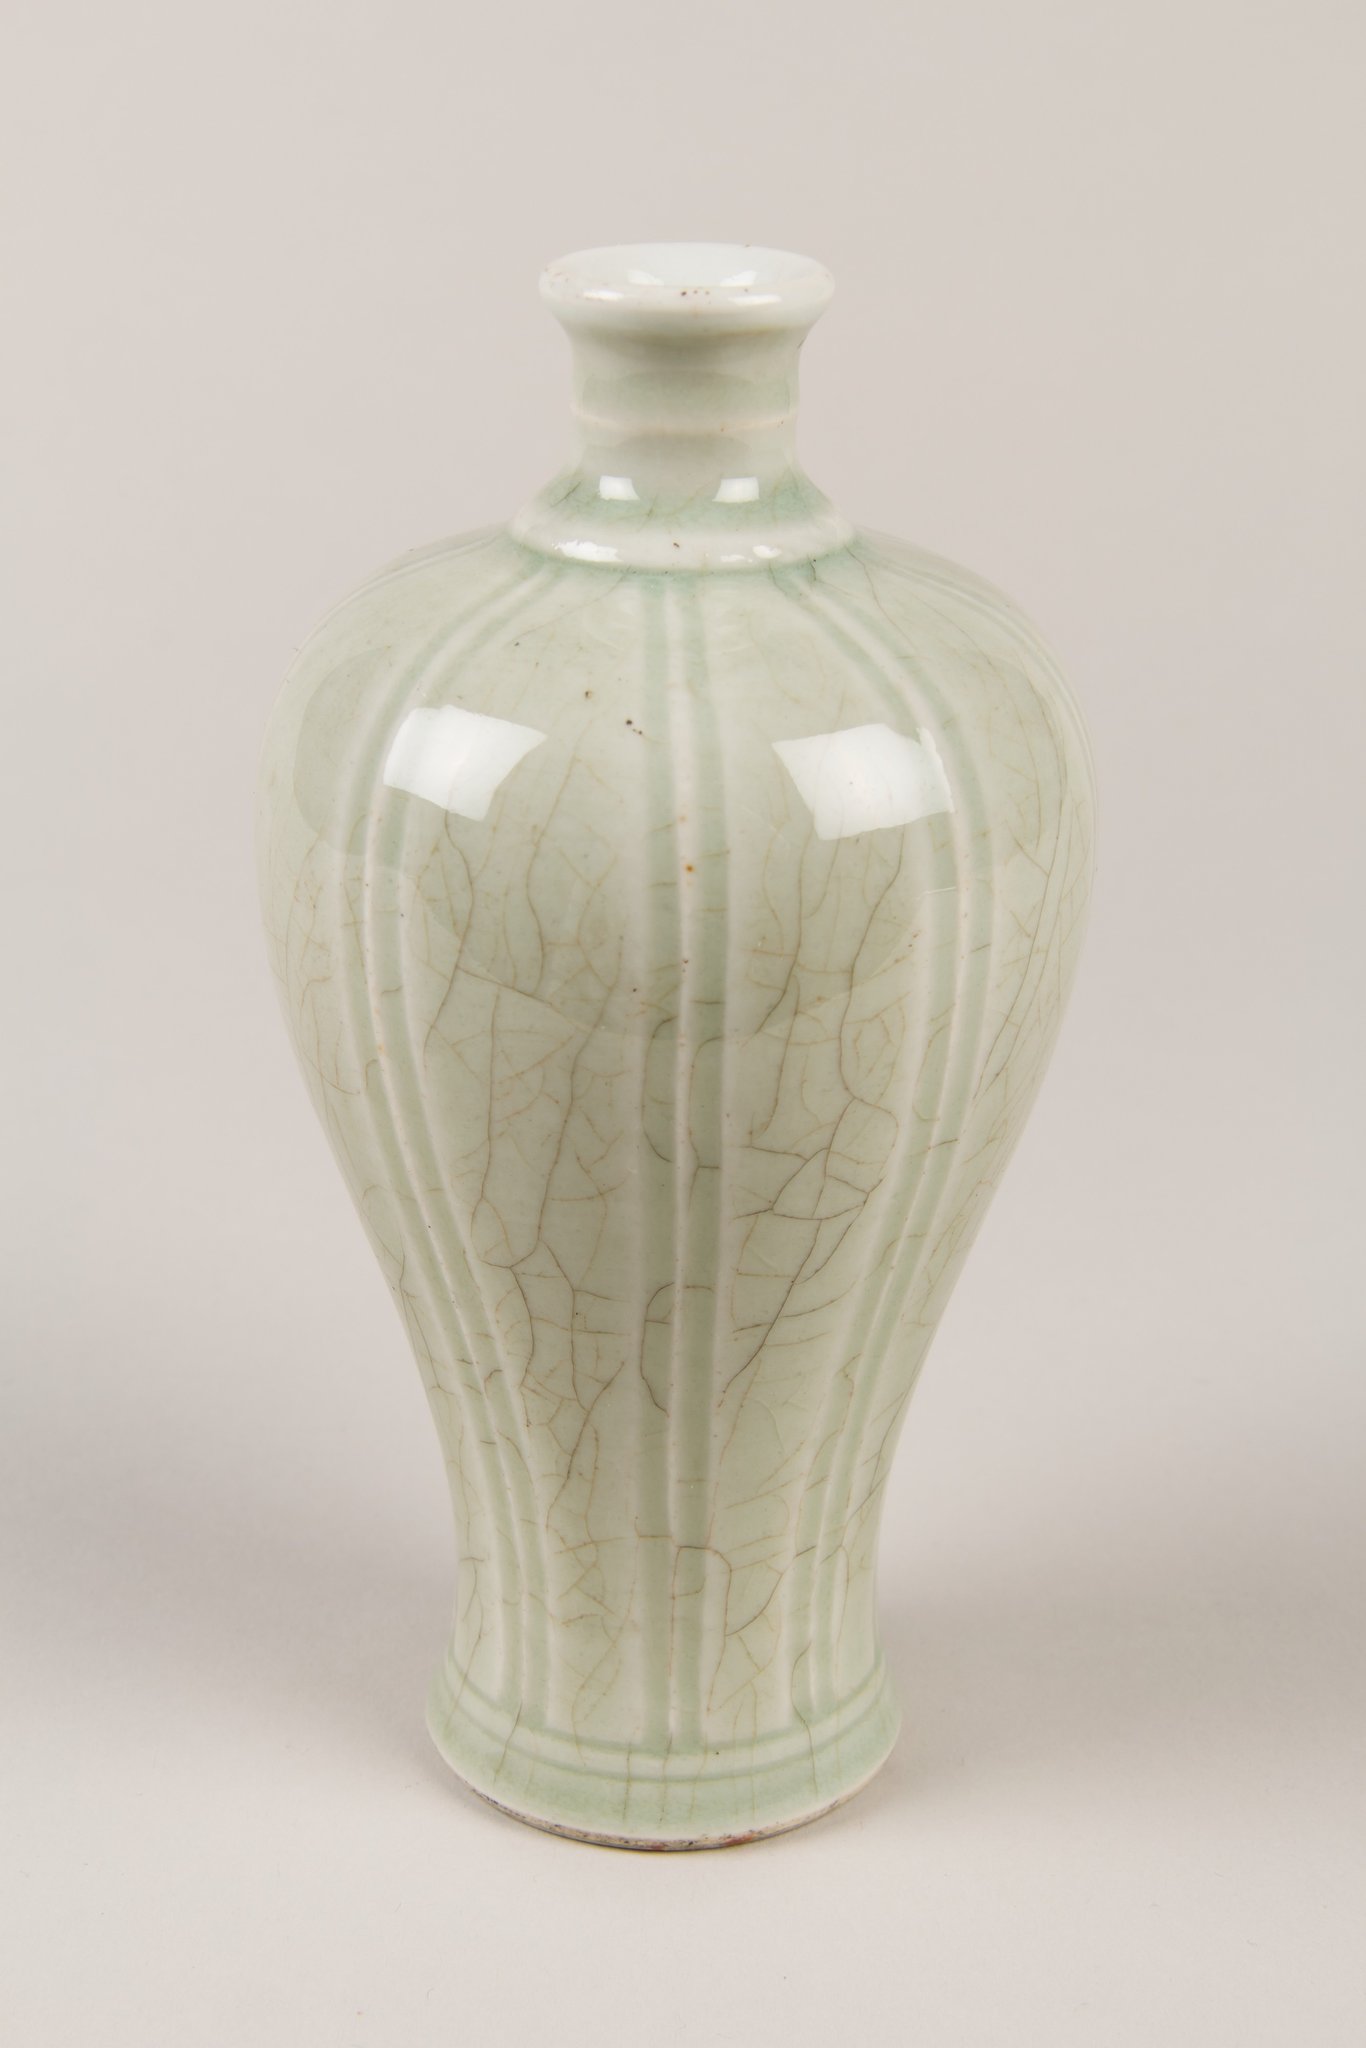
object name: vase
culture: chinese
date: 1701-1800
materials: ceramic glaze, glaze, porcelain